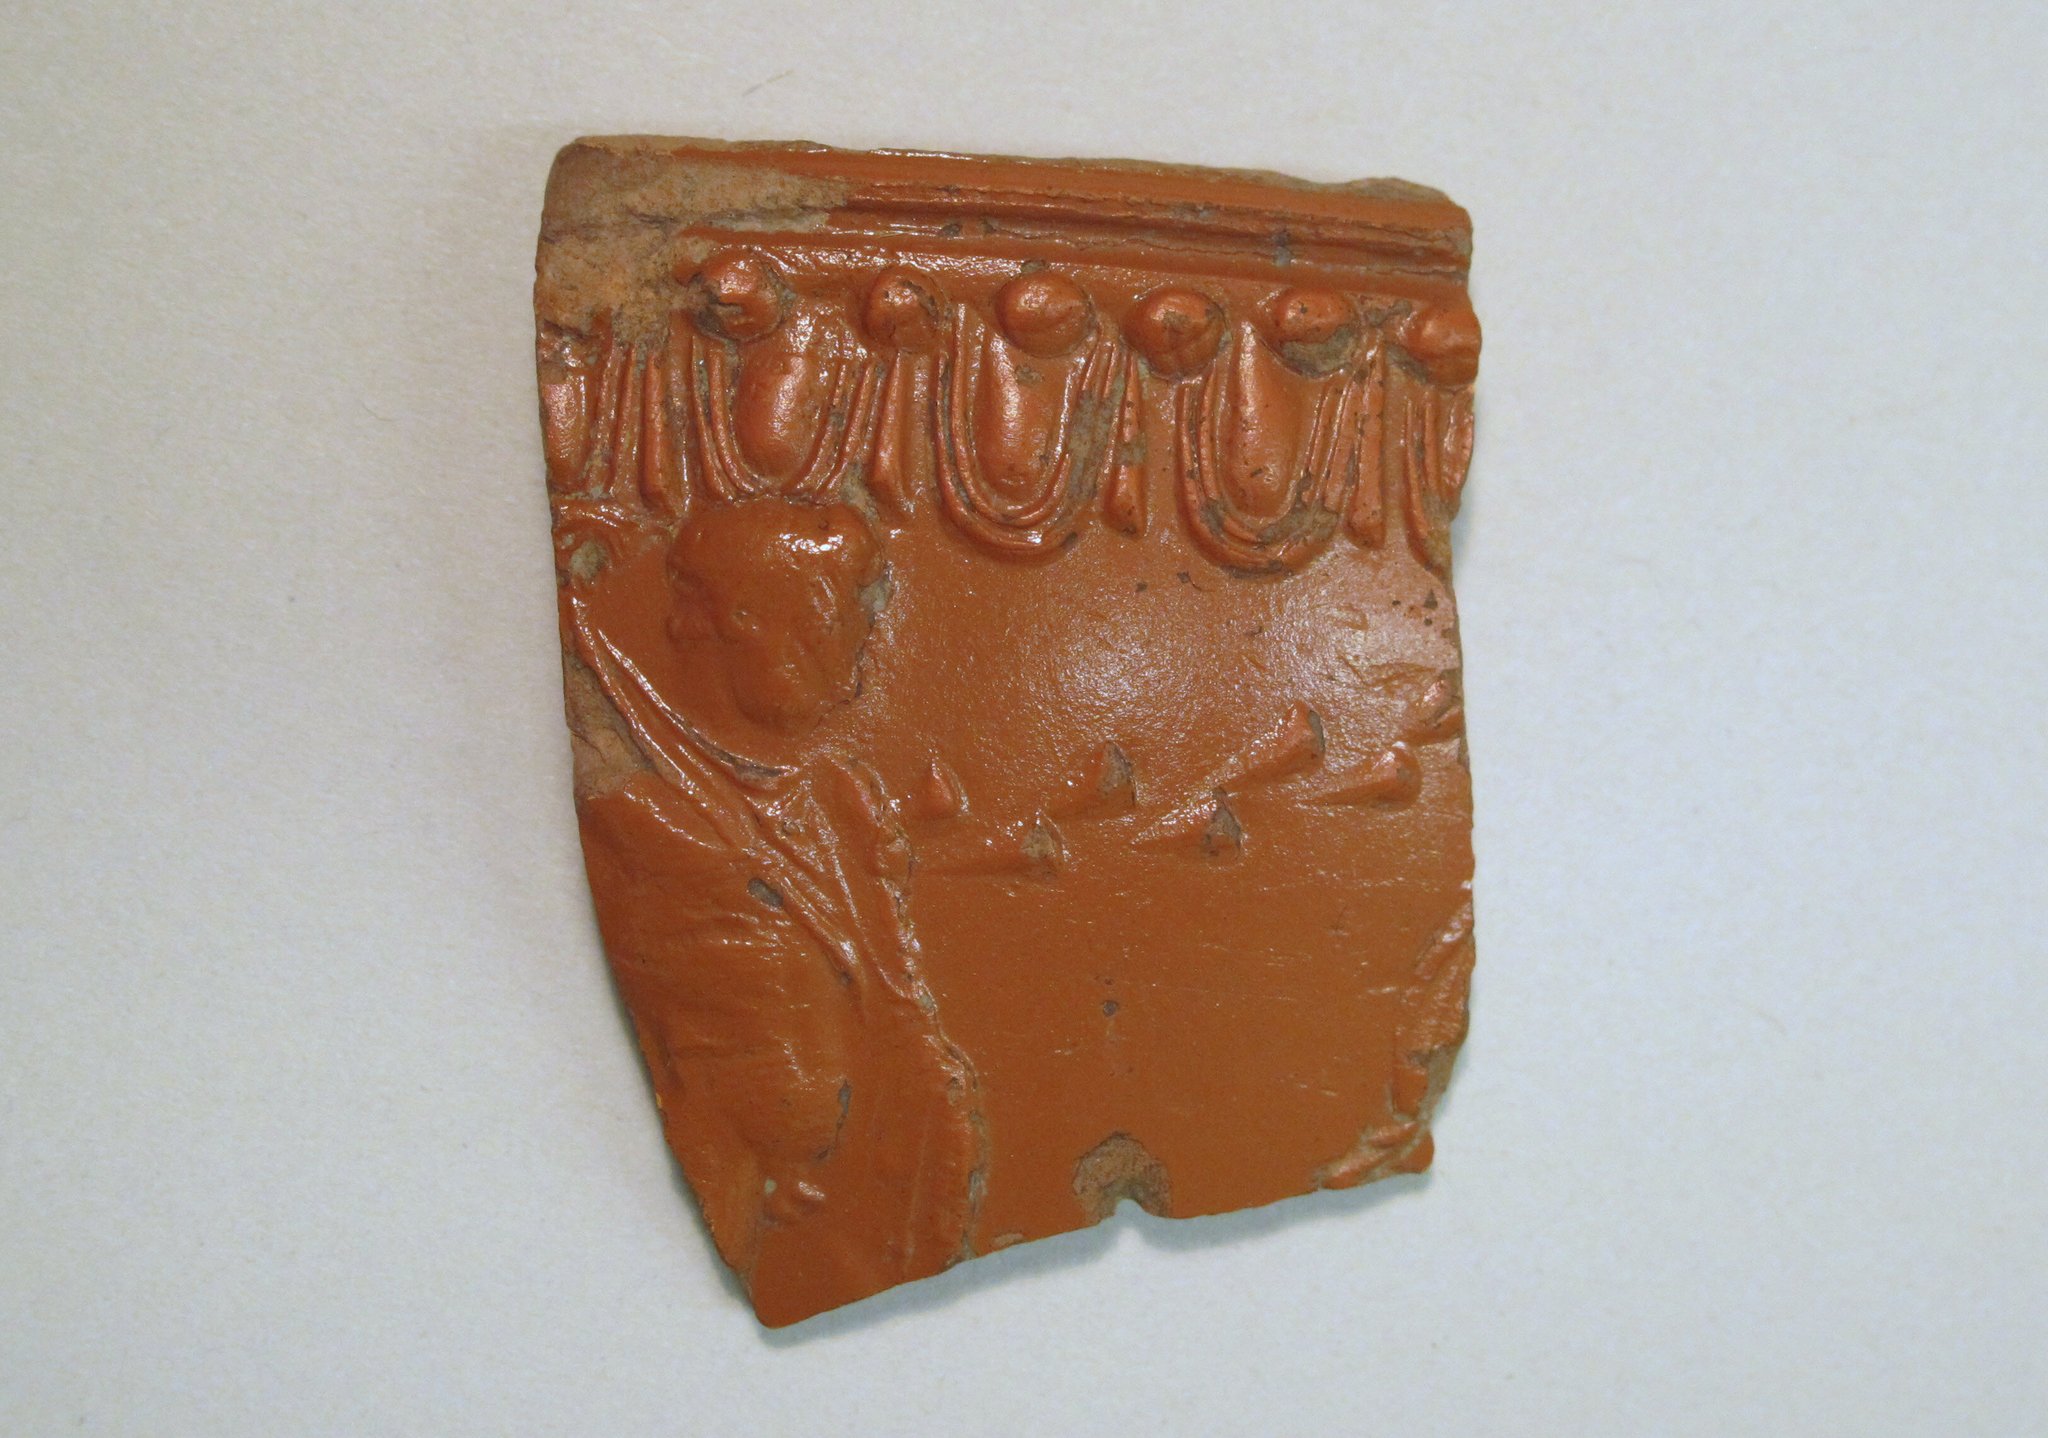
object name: vase fragment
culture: roman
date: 670 BCE-330 CE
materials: terracotta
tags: male nudes